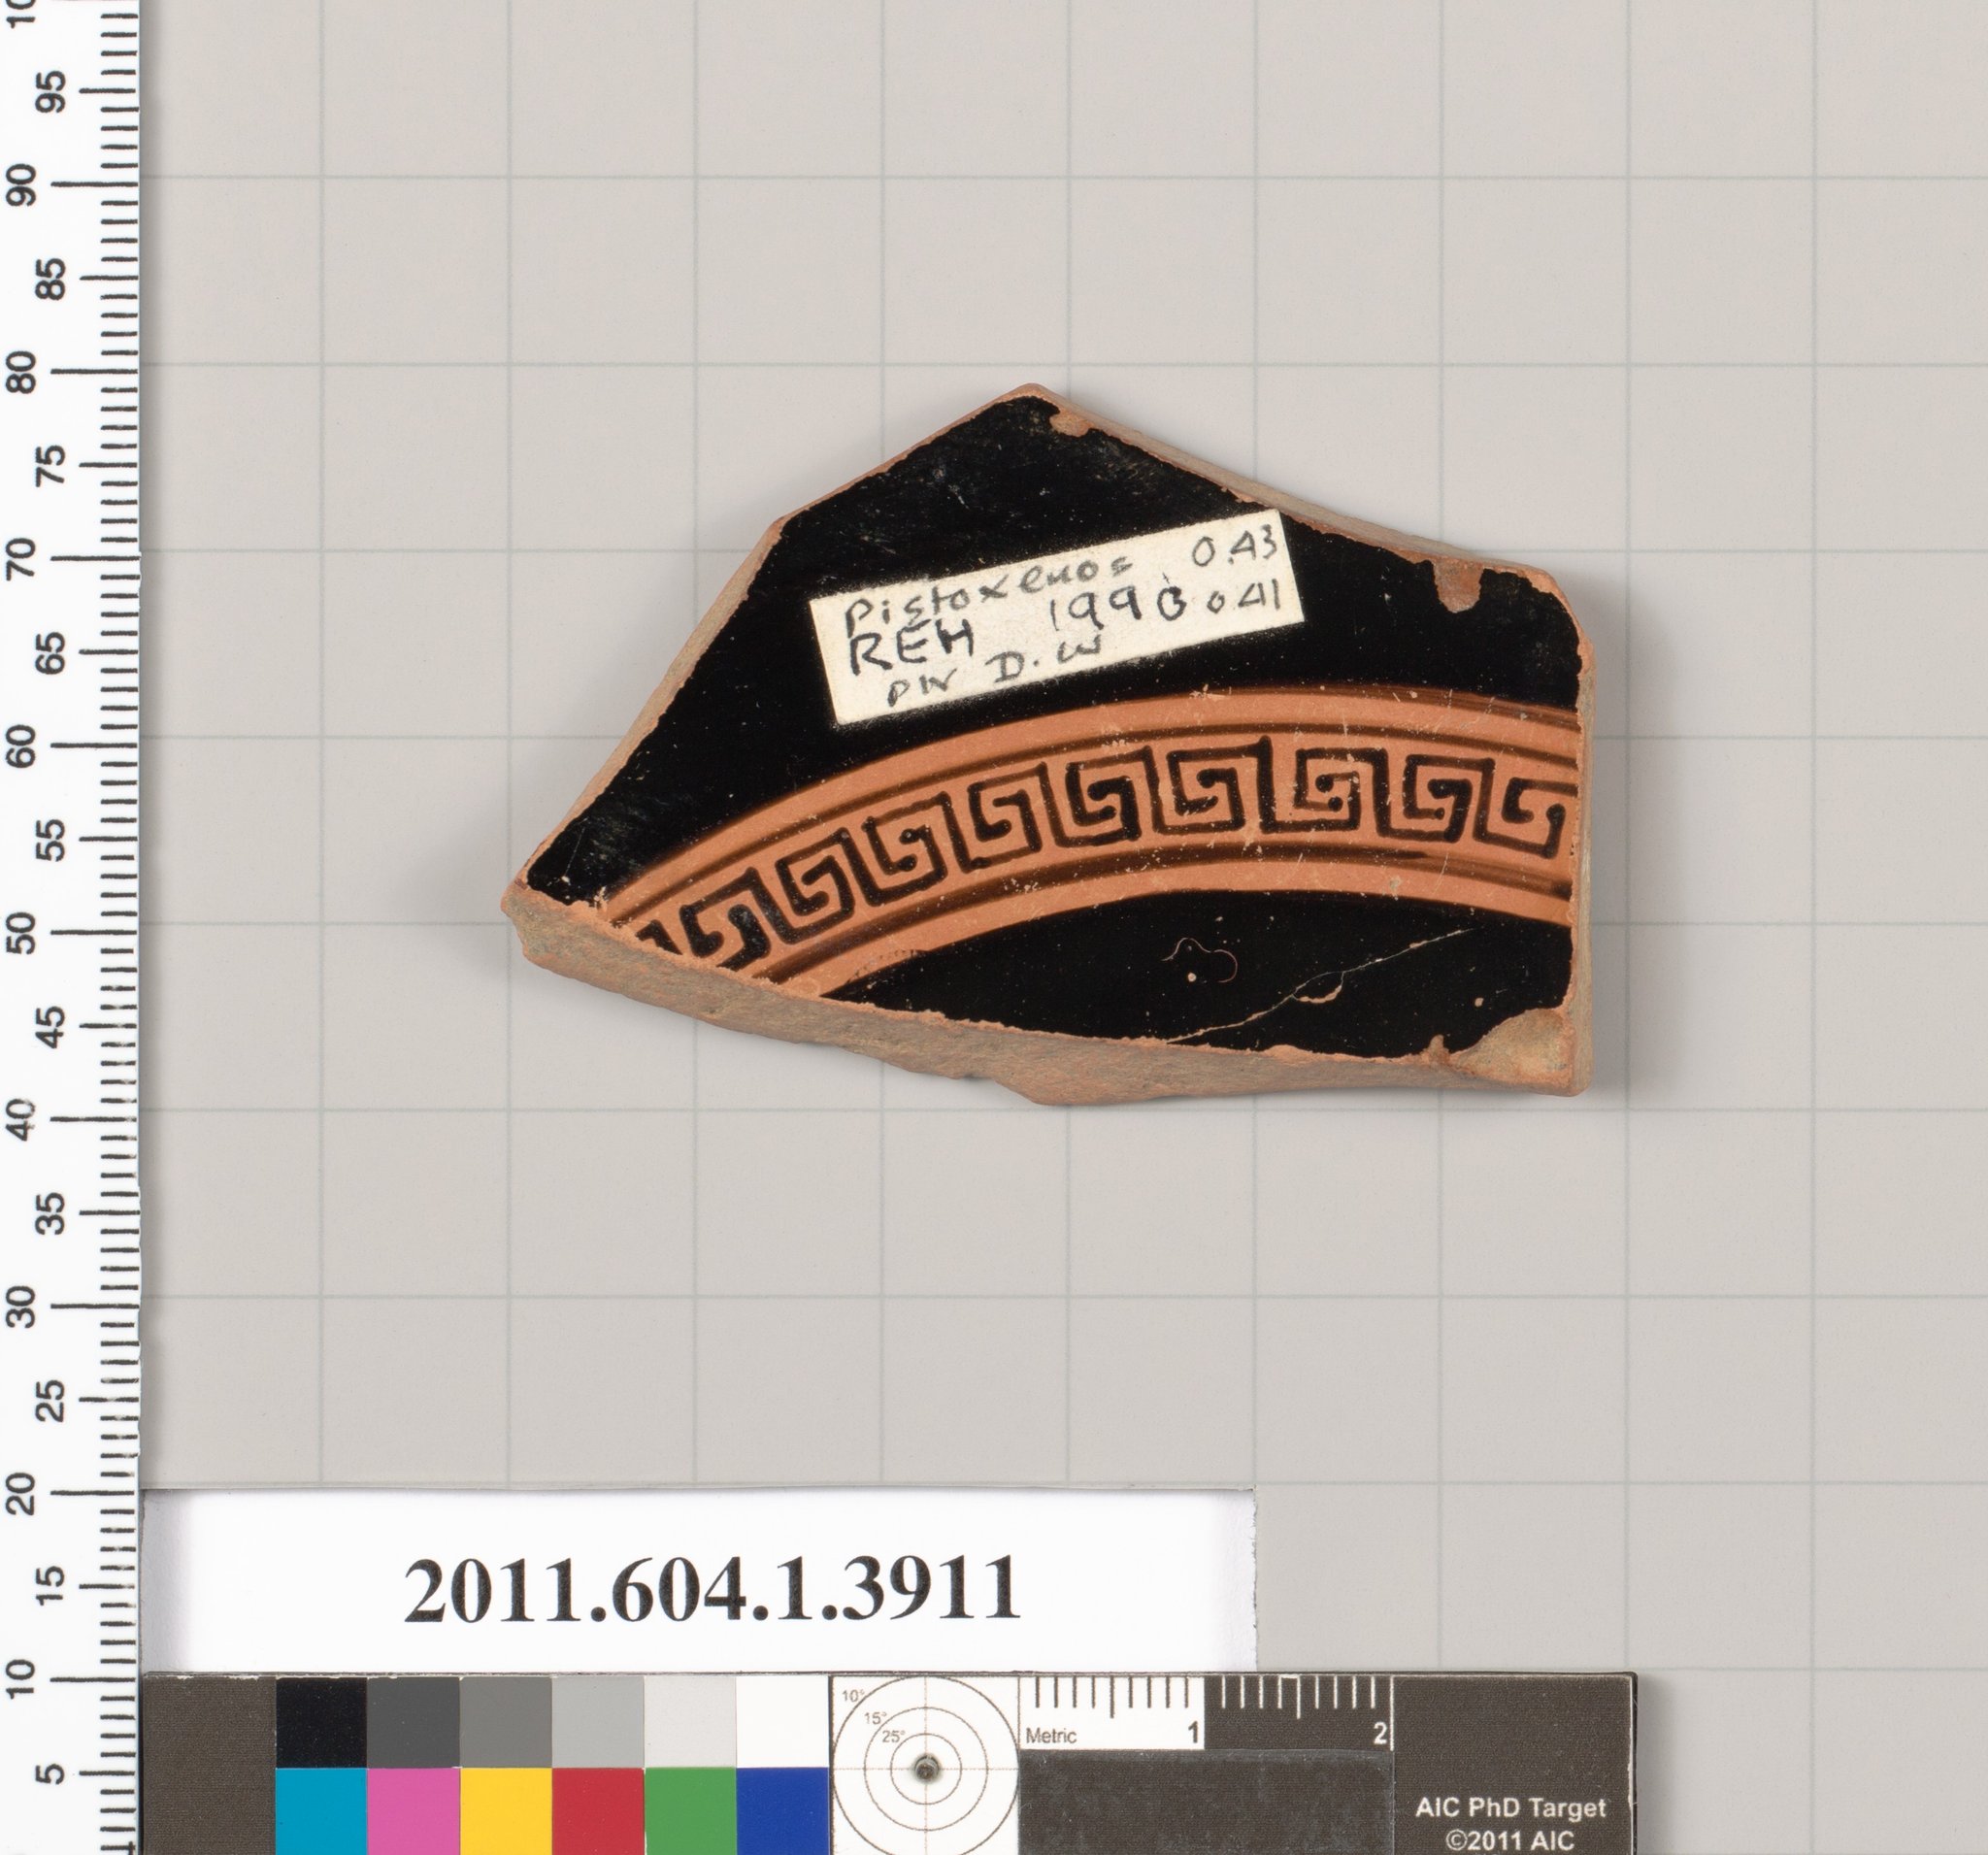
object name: kylix fragment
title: Terracotta fragment of a kylix (drinking cup)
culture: greek, attic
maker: pistoxenos painter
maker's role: artist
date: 475-451 BCE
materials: terracotta